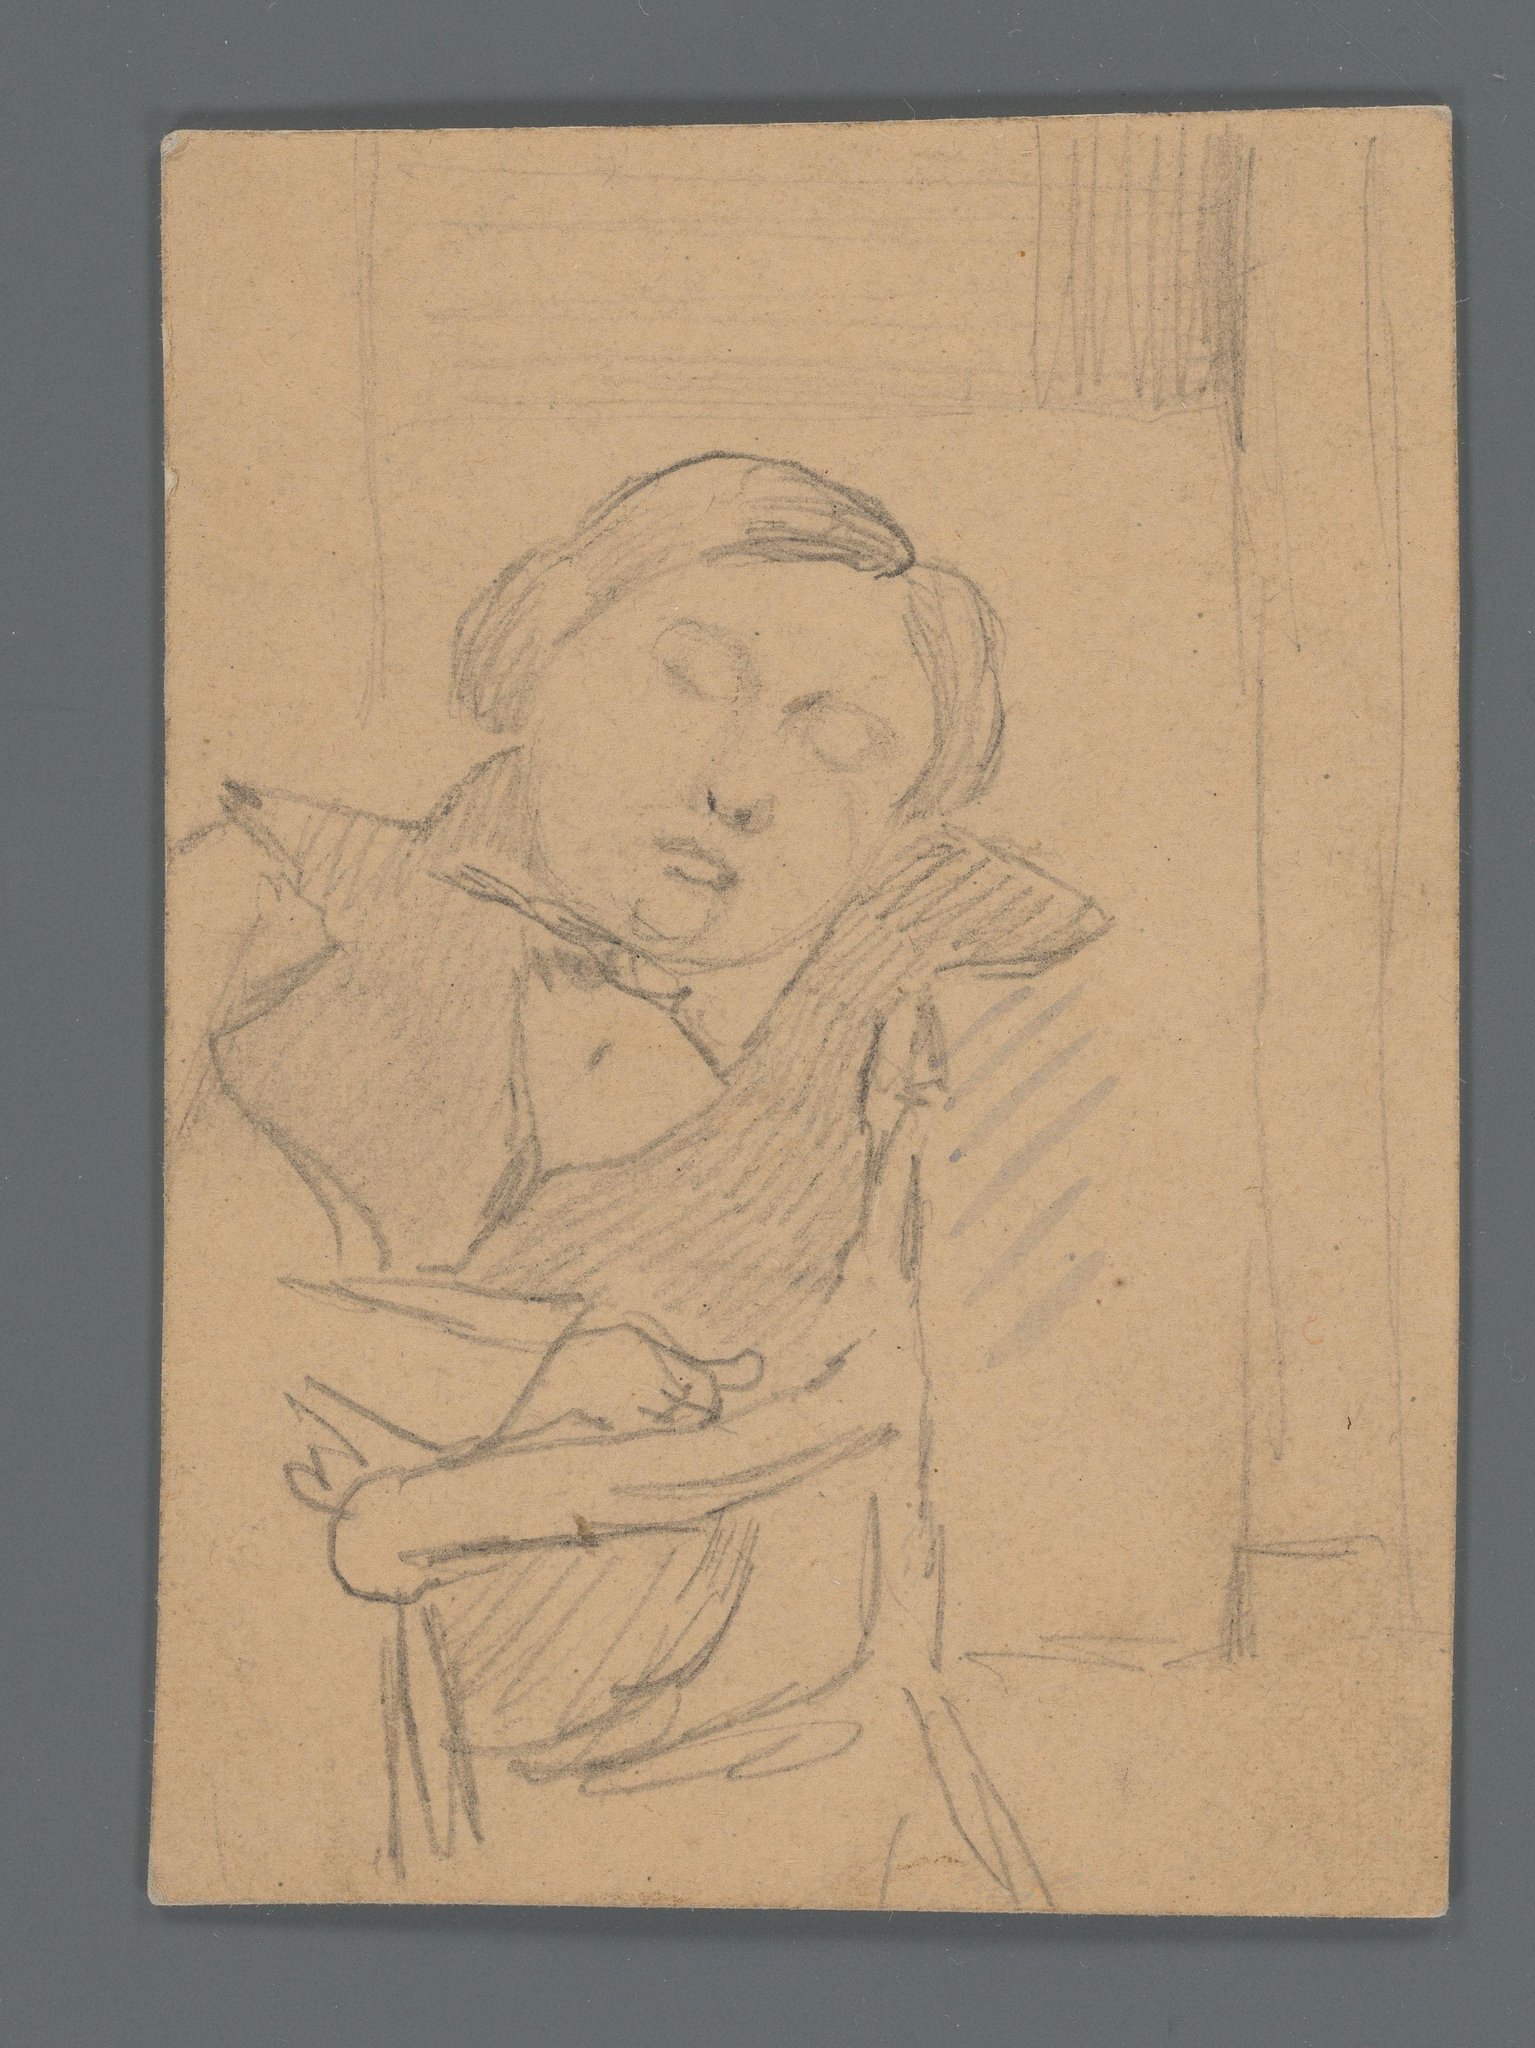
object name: drawing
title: Slapende man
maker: frederik lambertus geerling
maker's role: naval officer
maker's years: 1815-1894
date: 1840-1880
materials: cardboard, pencil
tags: sleeping in chair, historical persons not known by name